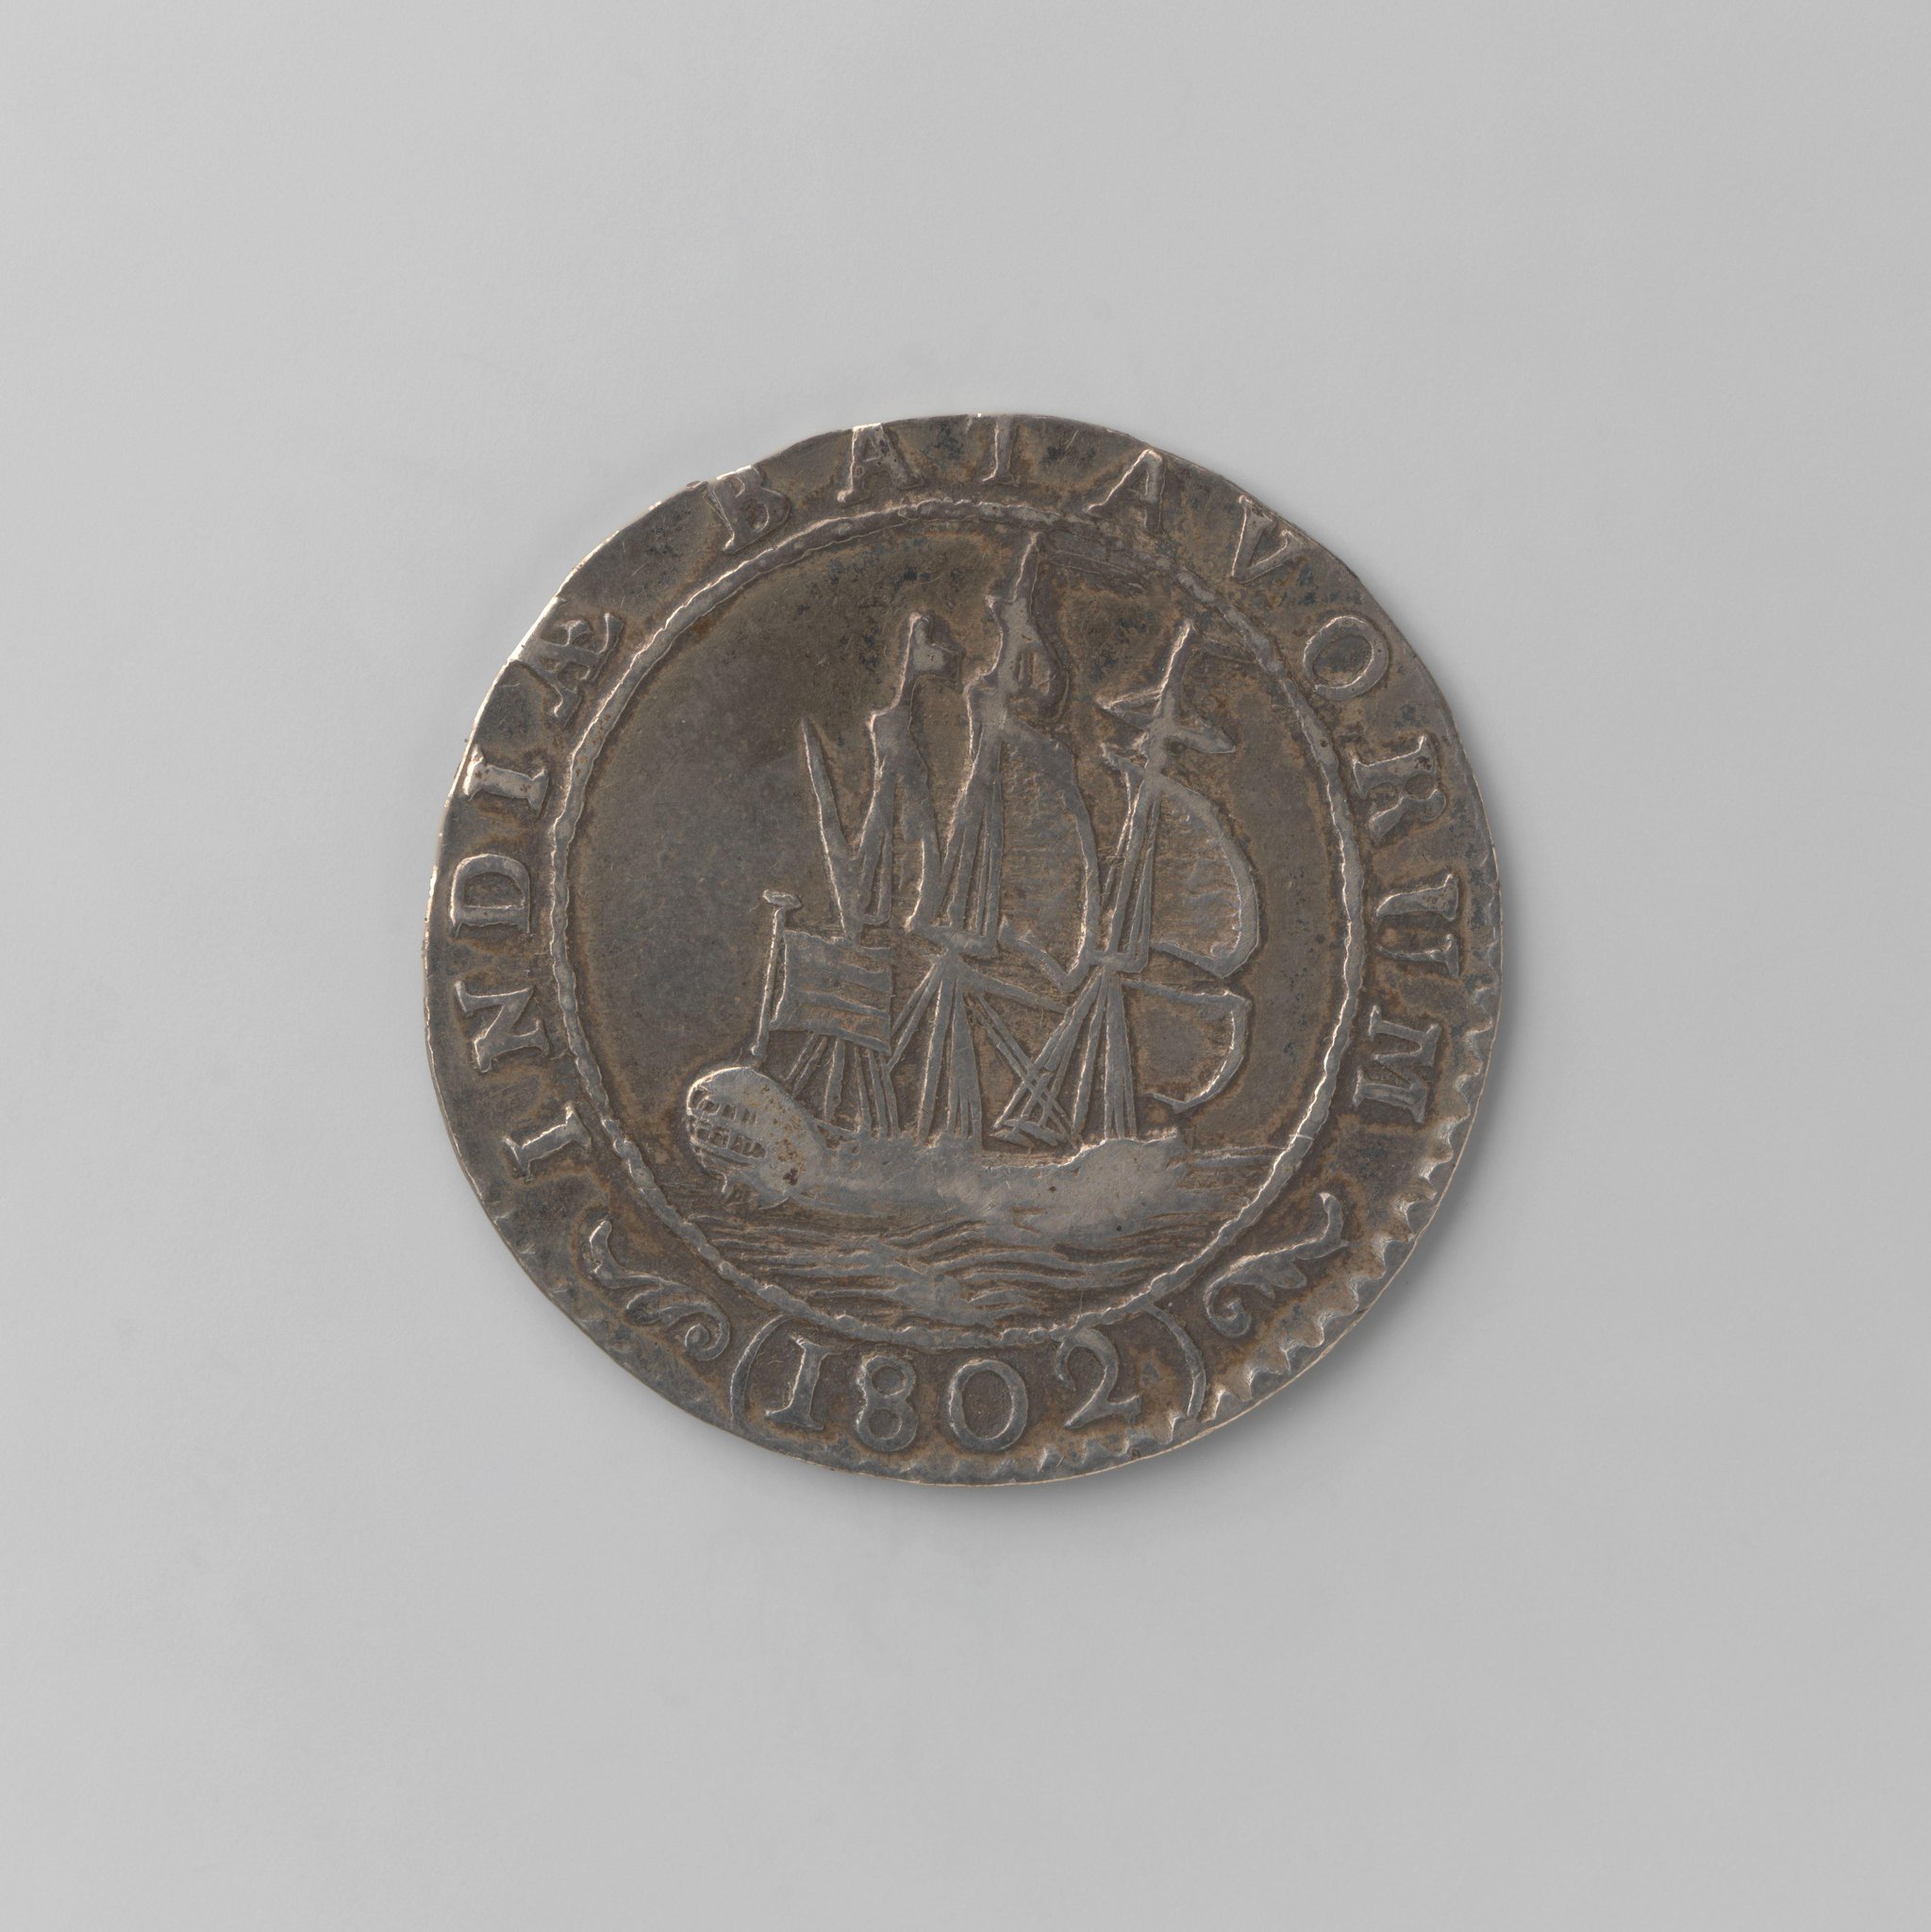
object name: coin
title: 1/4 gulden voor Nederlands Indië, 1802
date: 1802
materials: silver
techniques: striking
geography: enkhuizen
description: Zilveren munt. Voorzijde: Driemaster met volle zeilen op open zee. Versierd jaartal onderaan in omschrift. Keerzijde: tussen waarde-aanduiding 1/4 G gekroond generaliteitswapenschild. Muntteken boven kroon in omschrift. Kabelrand.